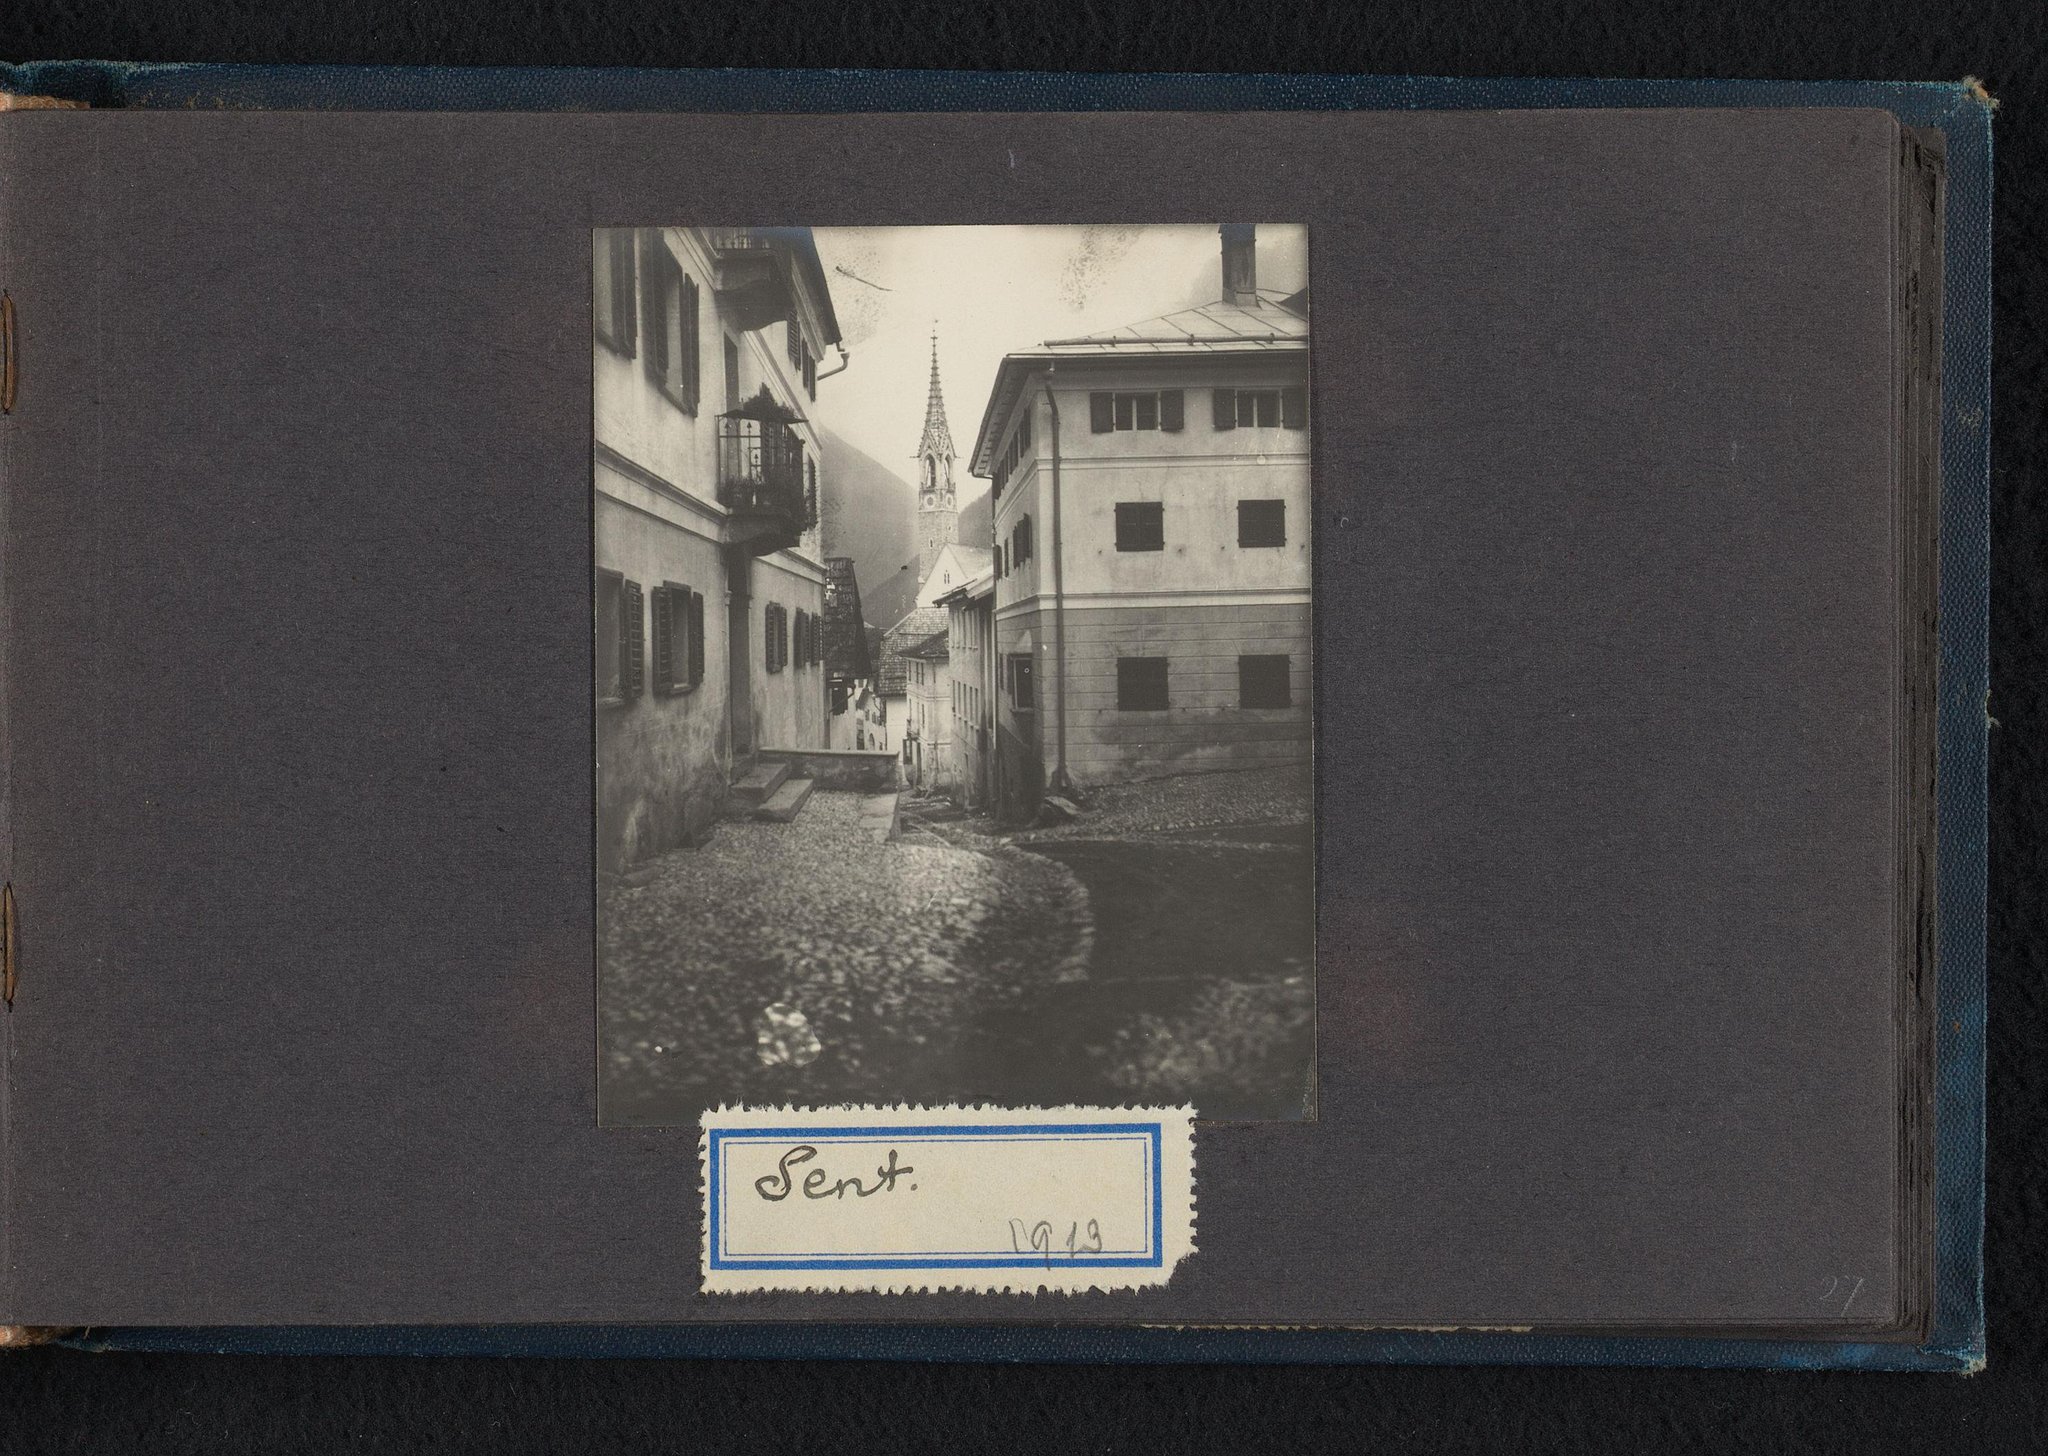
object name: photograph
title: Sent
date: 1913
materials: paper, photographic support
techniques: gelatin silver print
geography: switzerland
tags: else wachenheimer-moos, the family travelling, on holiday, public road, switzerland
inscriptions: inscription: ‘Sent. 1913’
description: Albumblad met een foto met een stadsgezicht in Sent, in Zwitserland. Onderdeel van het fotoalbum van Else Wachenheimer-Moos en haar broers Arthur en Willy Moos en anderen in de periode 1913-1918.